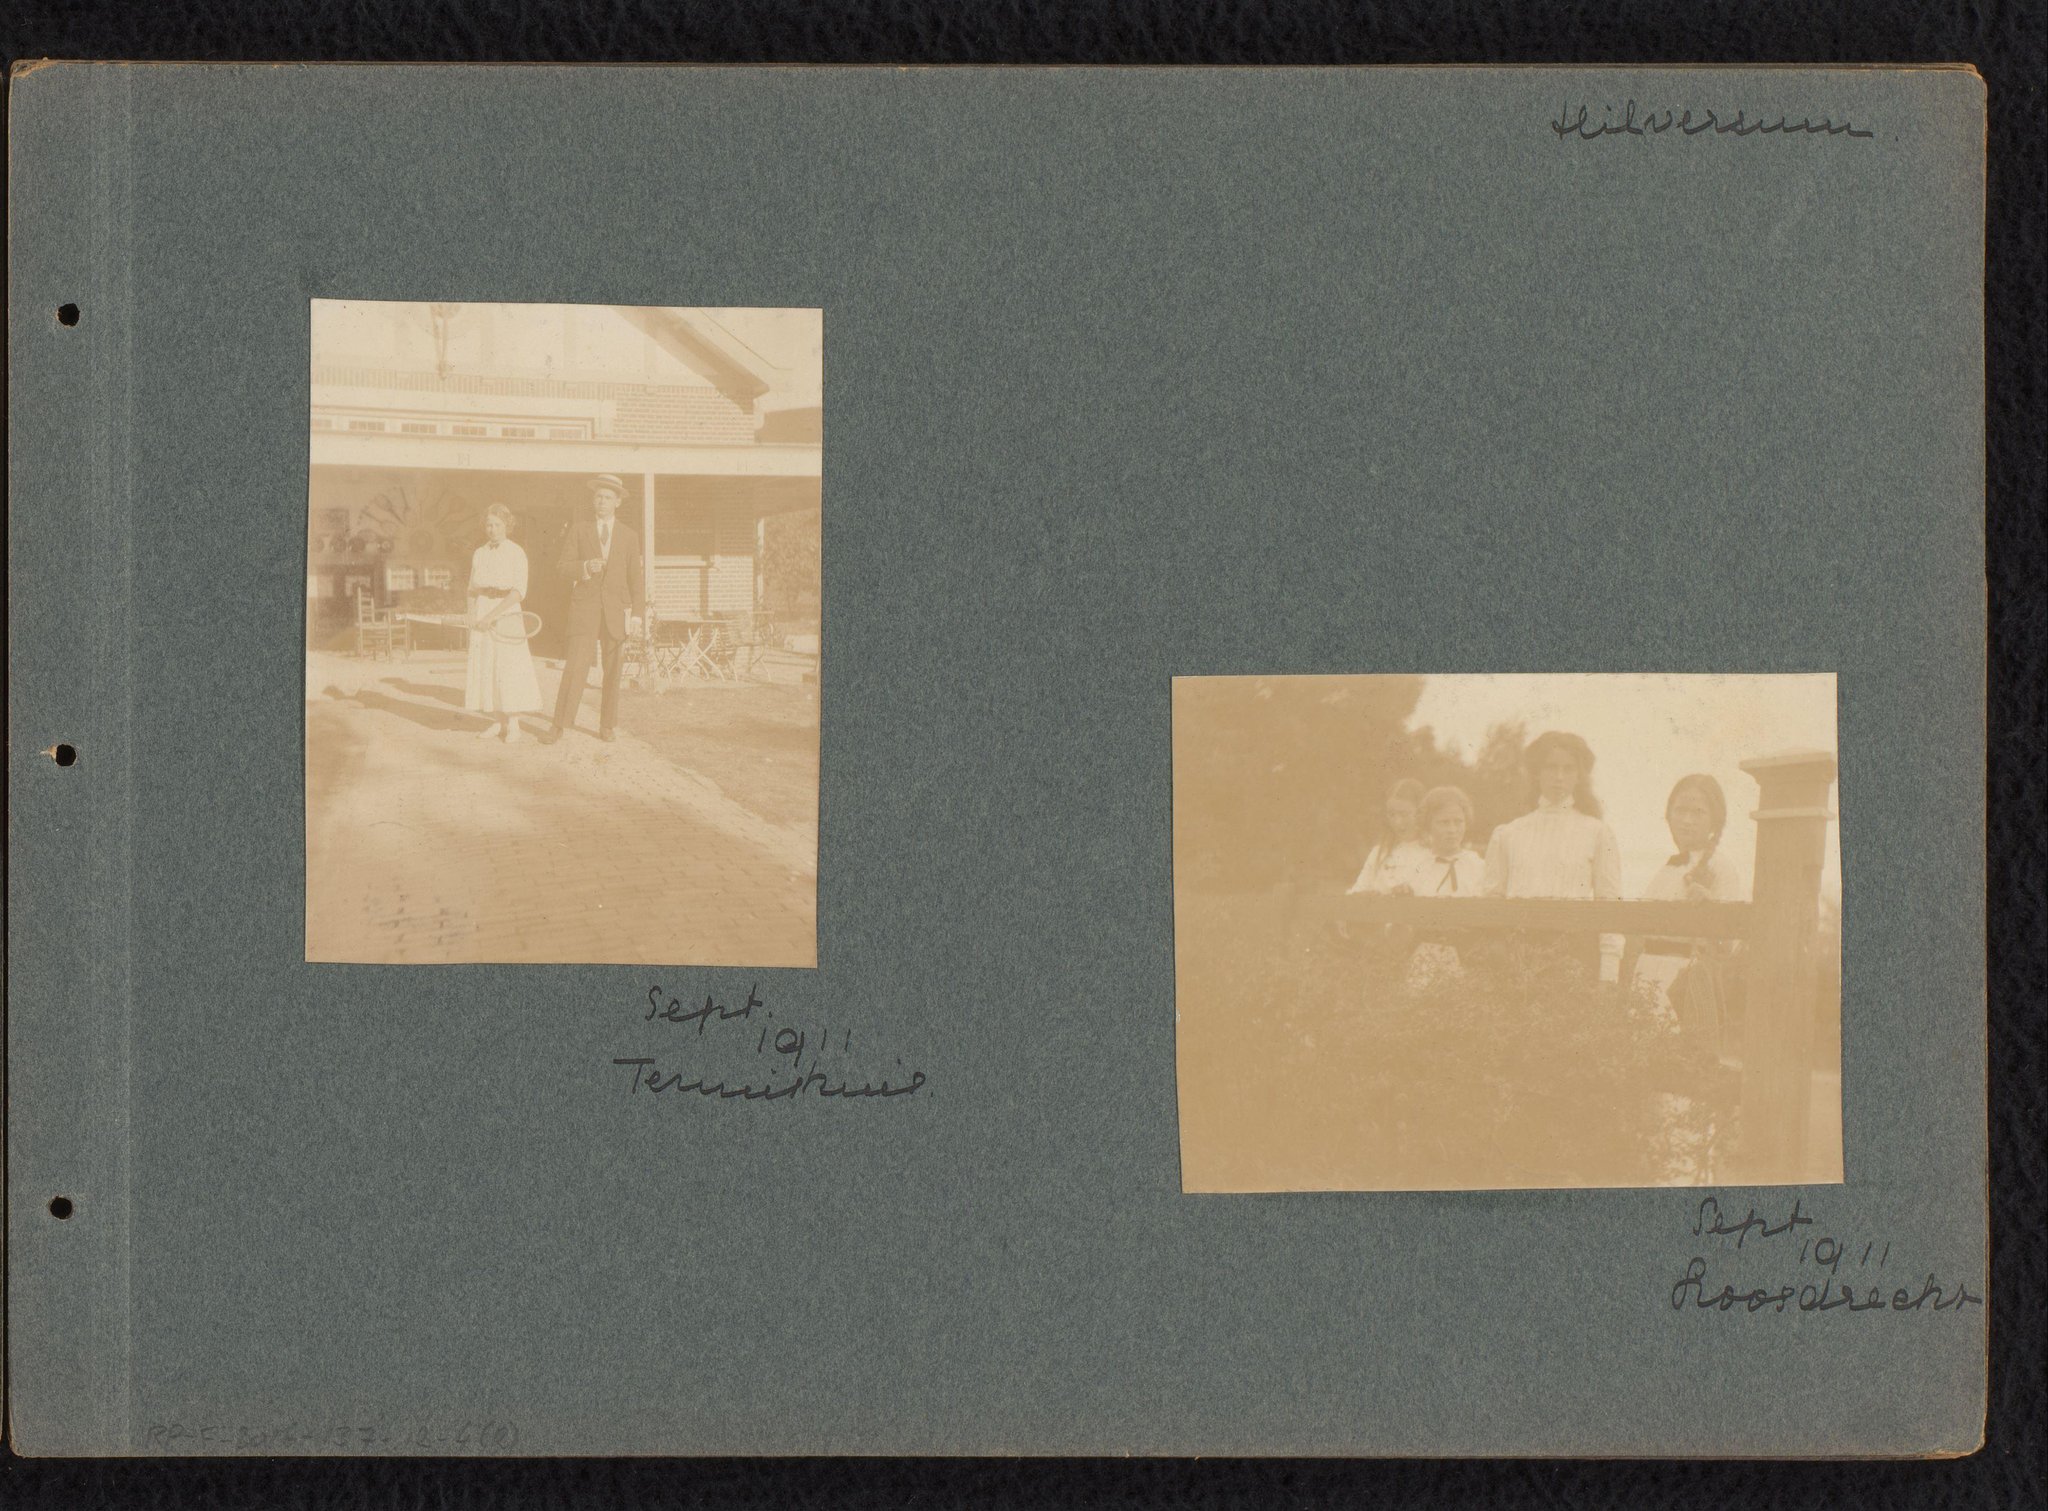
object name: album leaf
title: Loentje Onnen bij een tennishuis in Hilversum en met haar zus en twee andere meisjes in Loosdrecht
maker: carolina frederika onnen (lien/loen)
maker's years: 1896-1983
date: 1909-1911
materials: paper, cardboard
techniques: collodion silver print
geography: hilversum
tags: batavia, emilie albertina onnen (milly), amsterdam, carolina frederika onnen (lien/loen), tennis, lawn-tennis, historical persons - bb - woman, anonymous historical persons portrayed in a group, in a group-portrait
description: Deze foto's zijn onderdeel van een album.